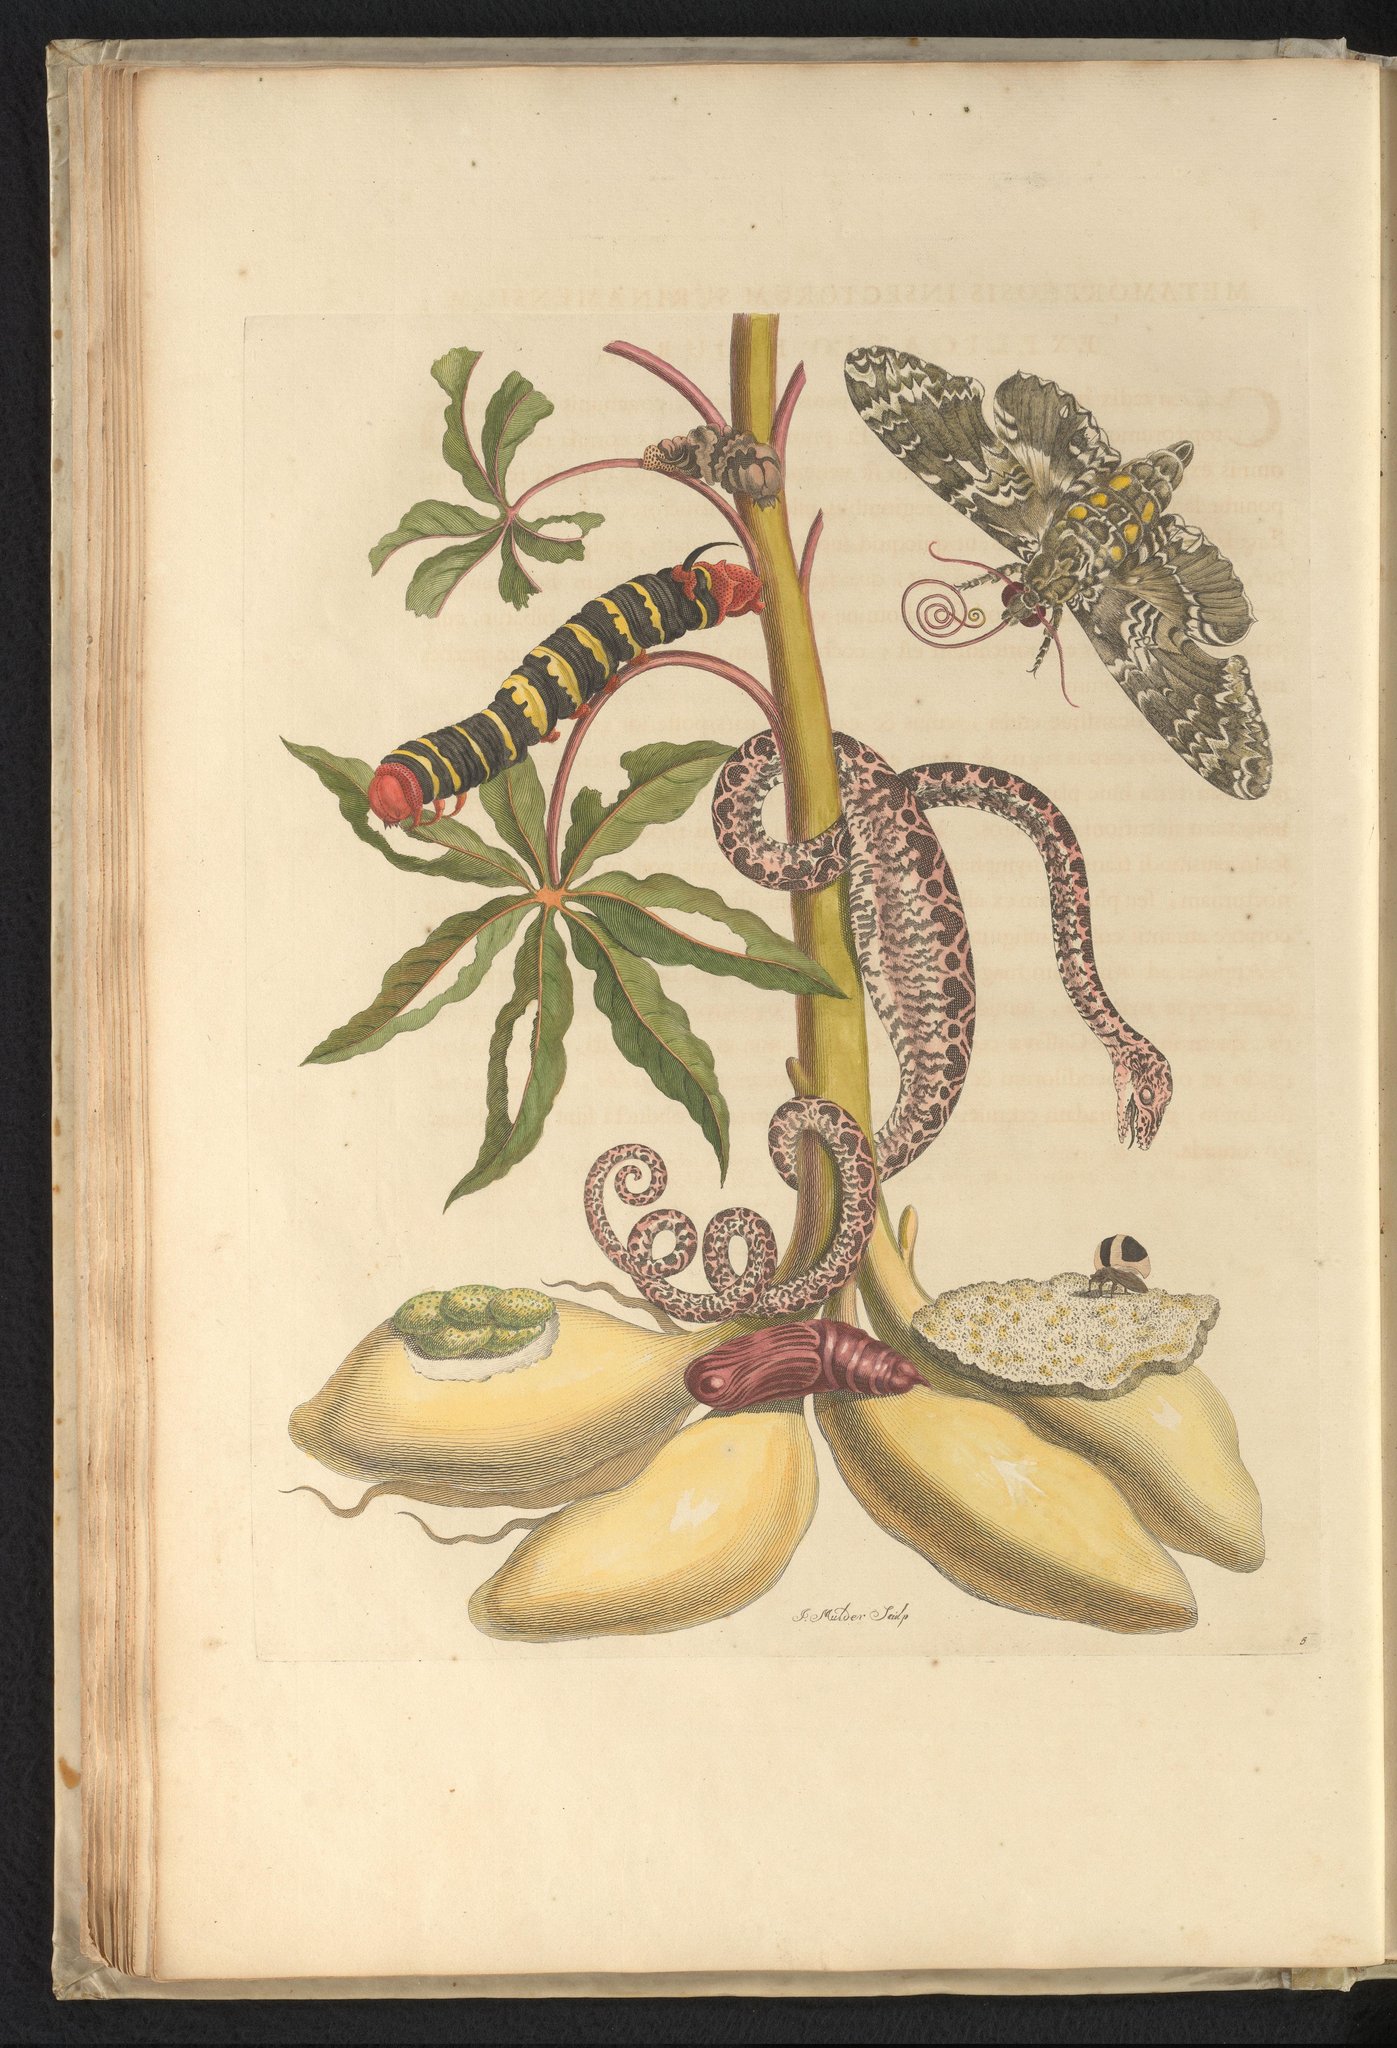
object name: print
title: Cassave (Manihot esculenta) met nachtvlinder, rups, tuinboa en verschillende insecten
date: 1705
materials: paper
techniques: etching, hand coloring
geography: amsterdam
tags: insects: pupa, plants and herbs: cassava, snakes: boa, insects: moth, insects: caterpillar, suriname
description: Rechtsonder genummerd: 5. Prent maakt deel uit van een boek.